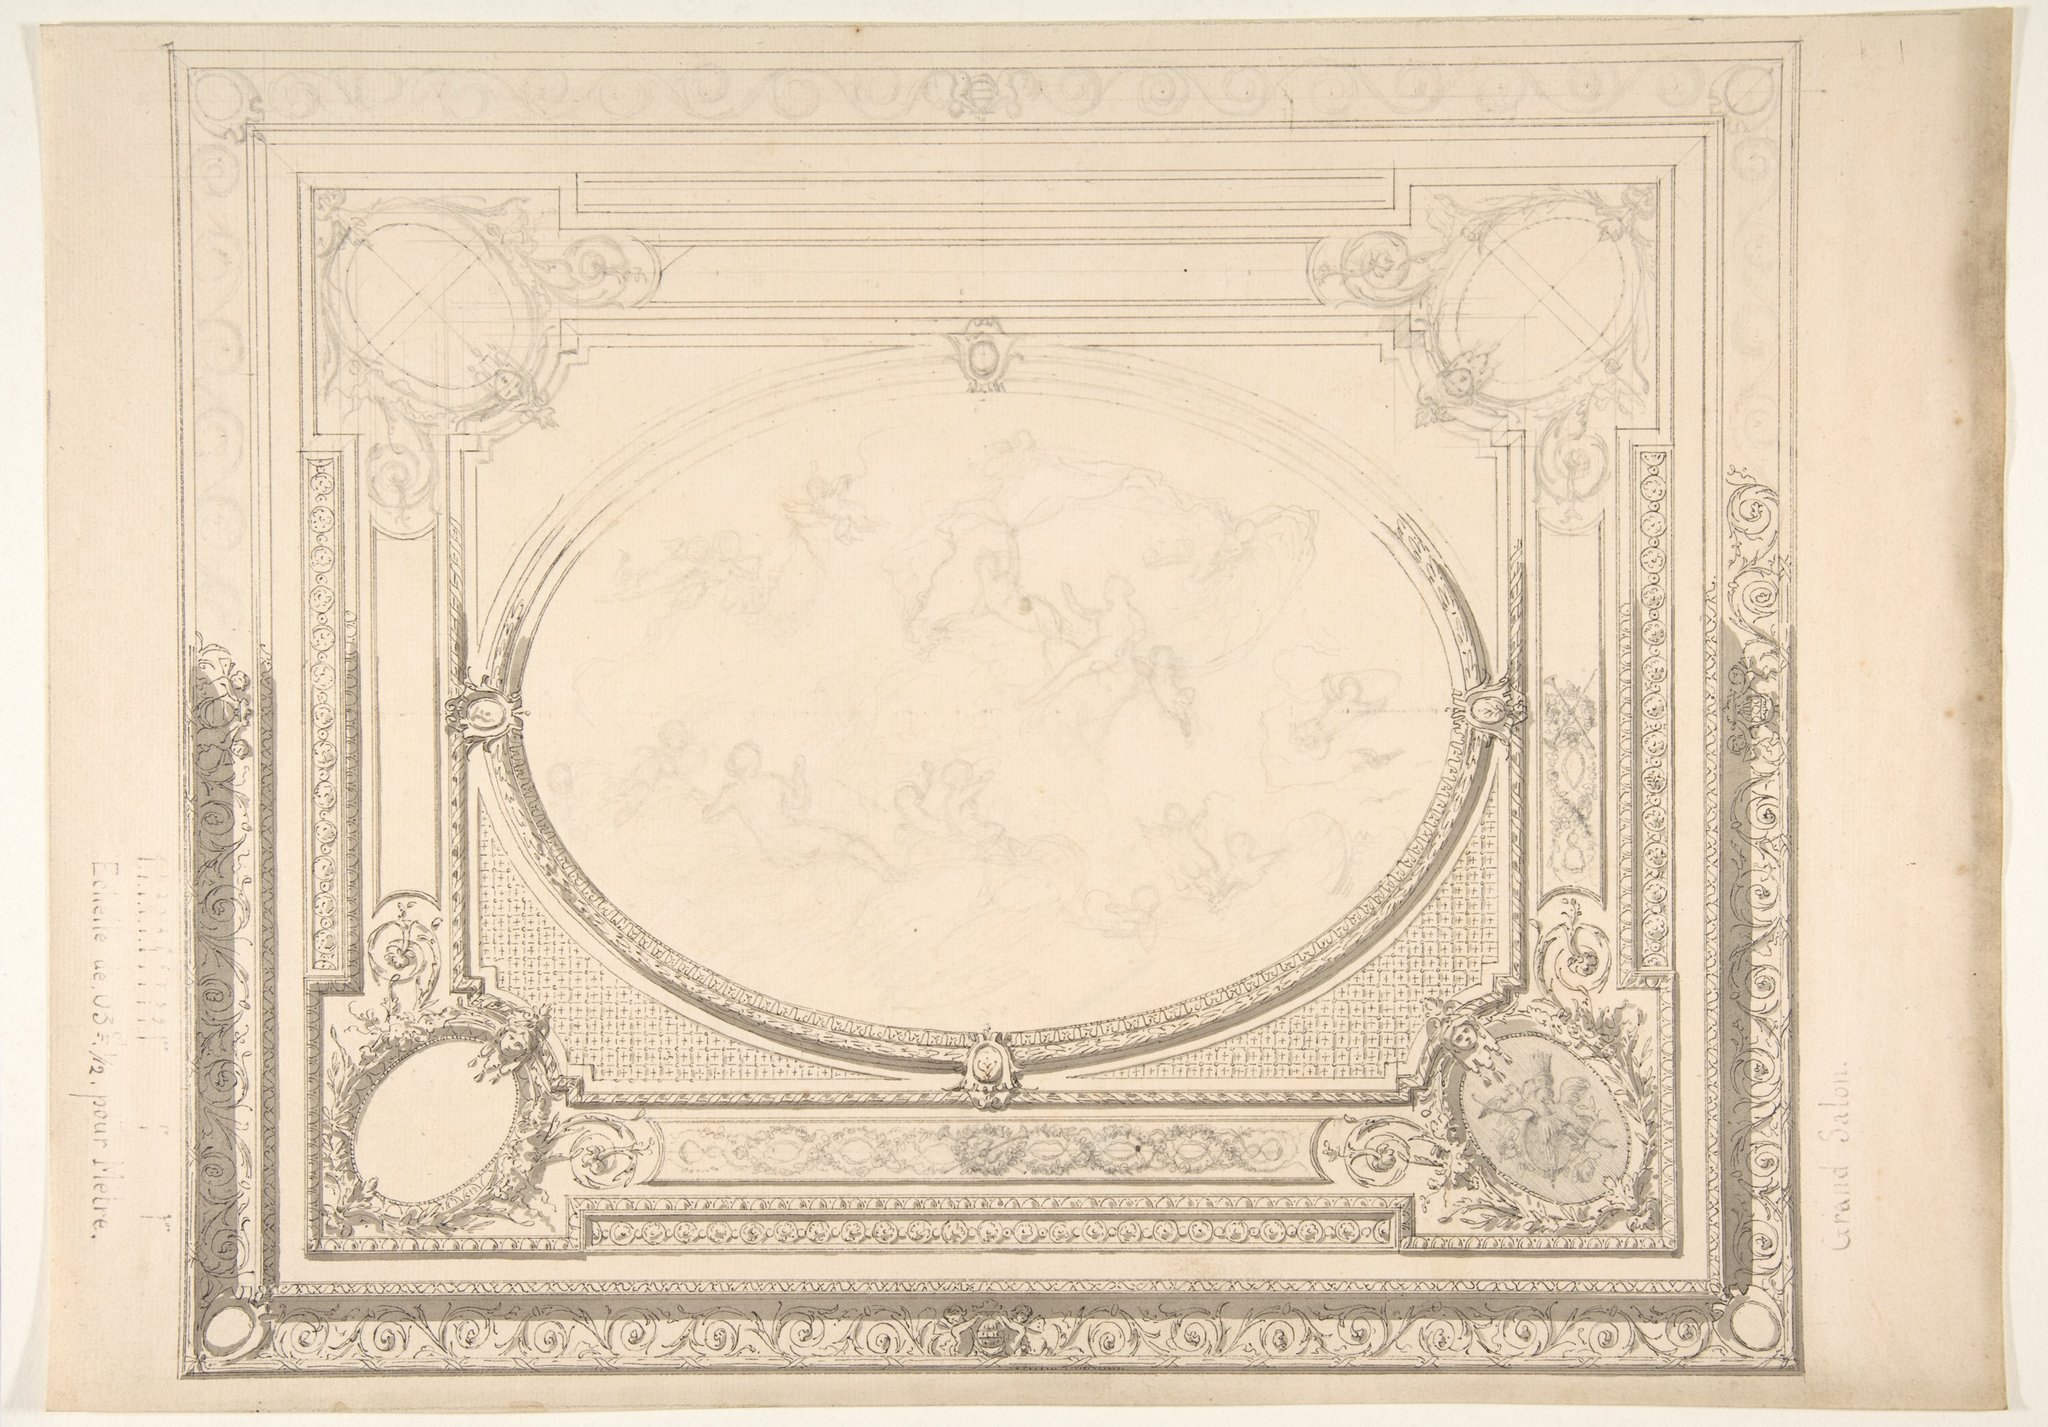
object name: drawing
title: Design for a ceiling: the Grand Salon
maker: jules-edmond-charles lachaise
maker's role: artist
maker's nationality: french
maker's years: 1897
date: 1851-1900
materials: graphite, ink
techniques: pen, wash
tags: ornament